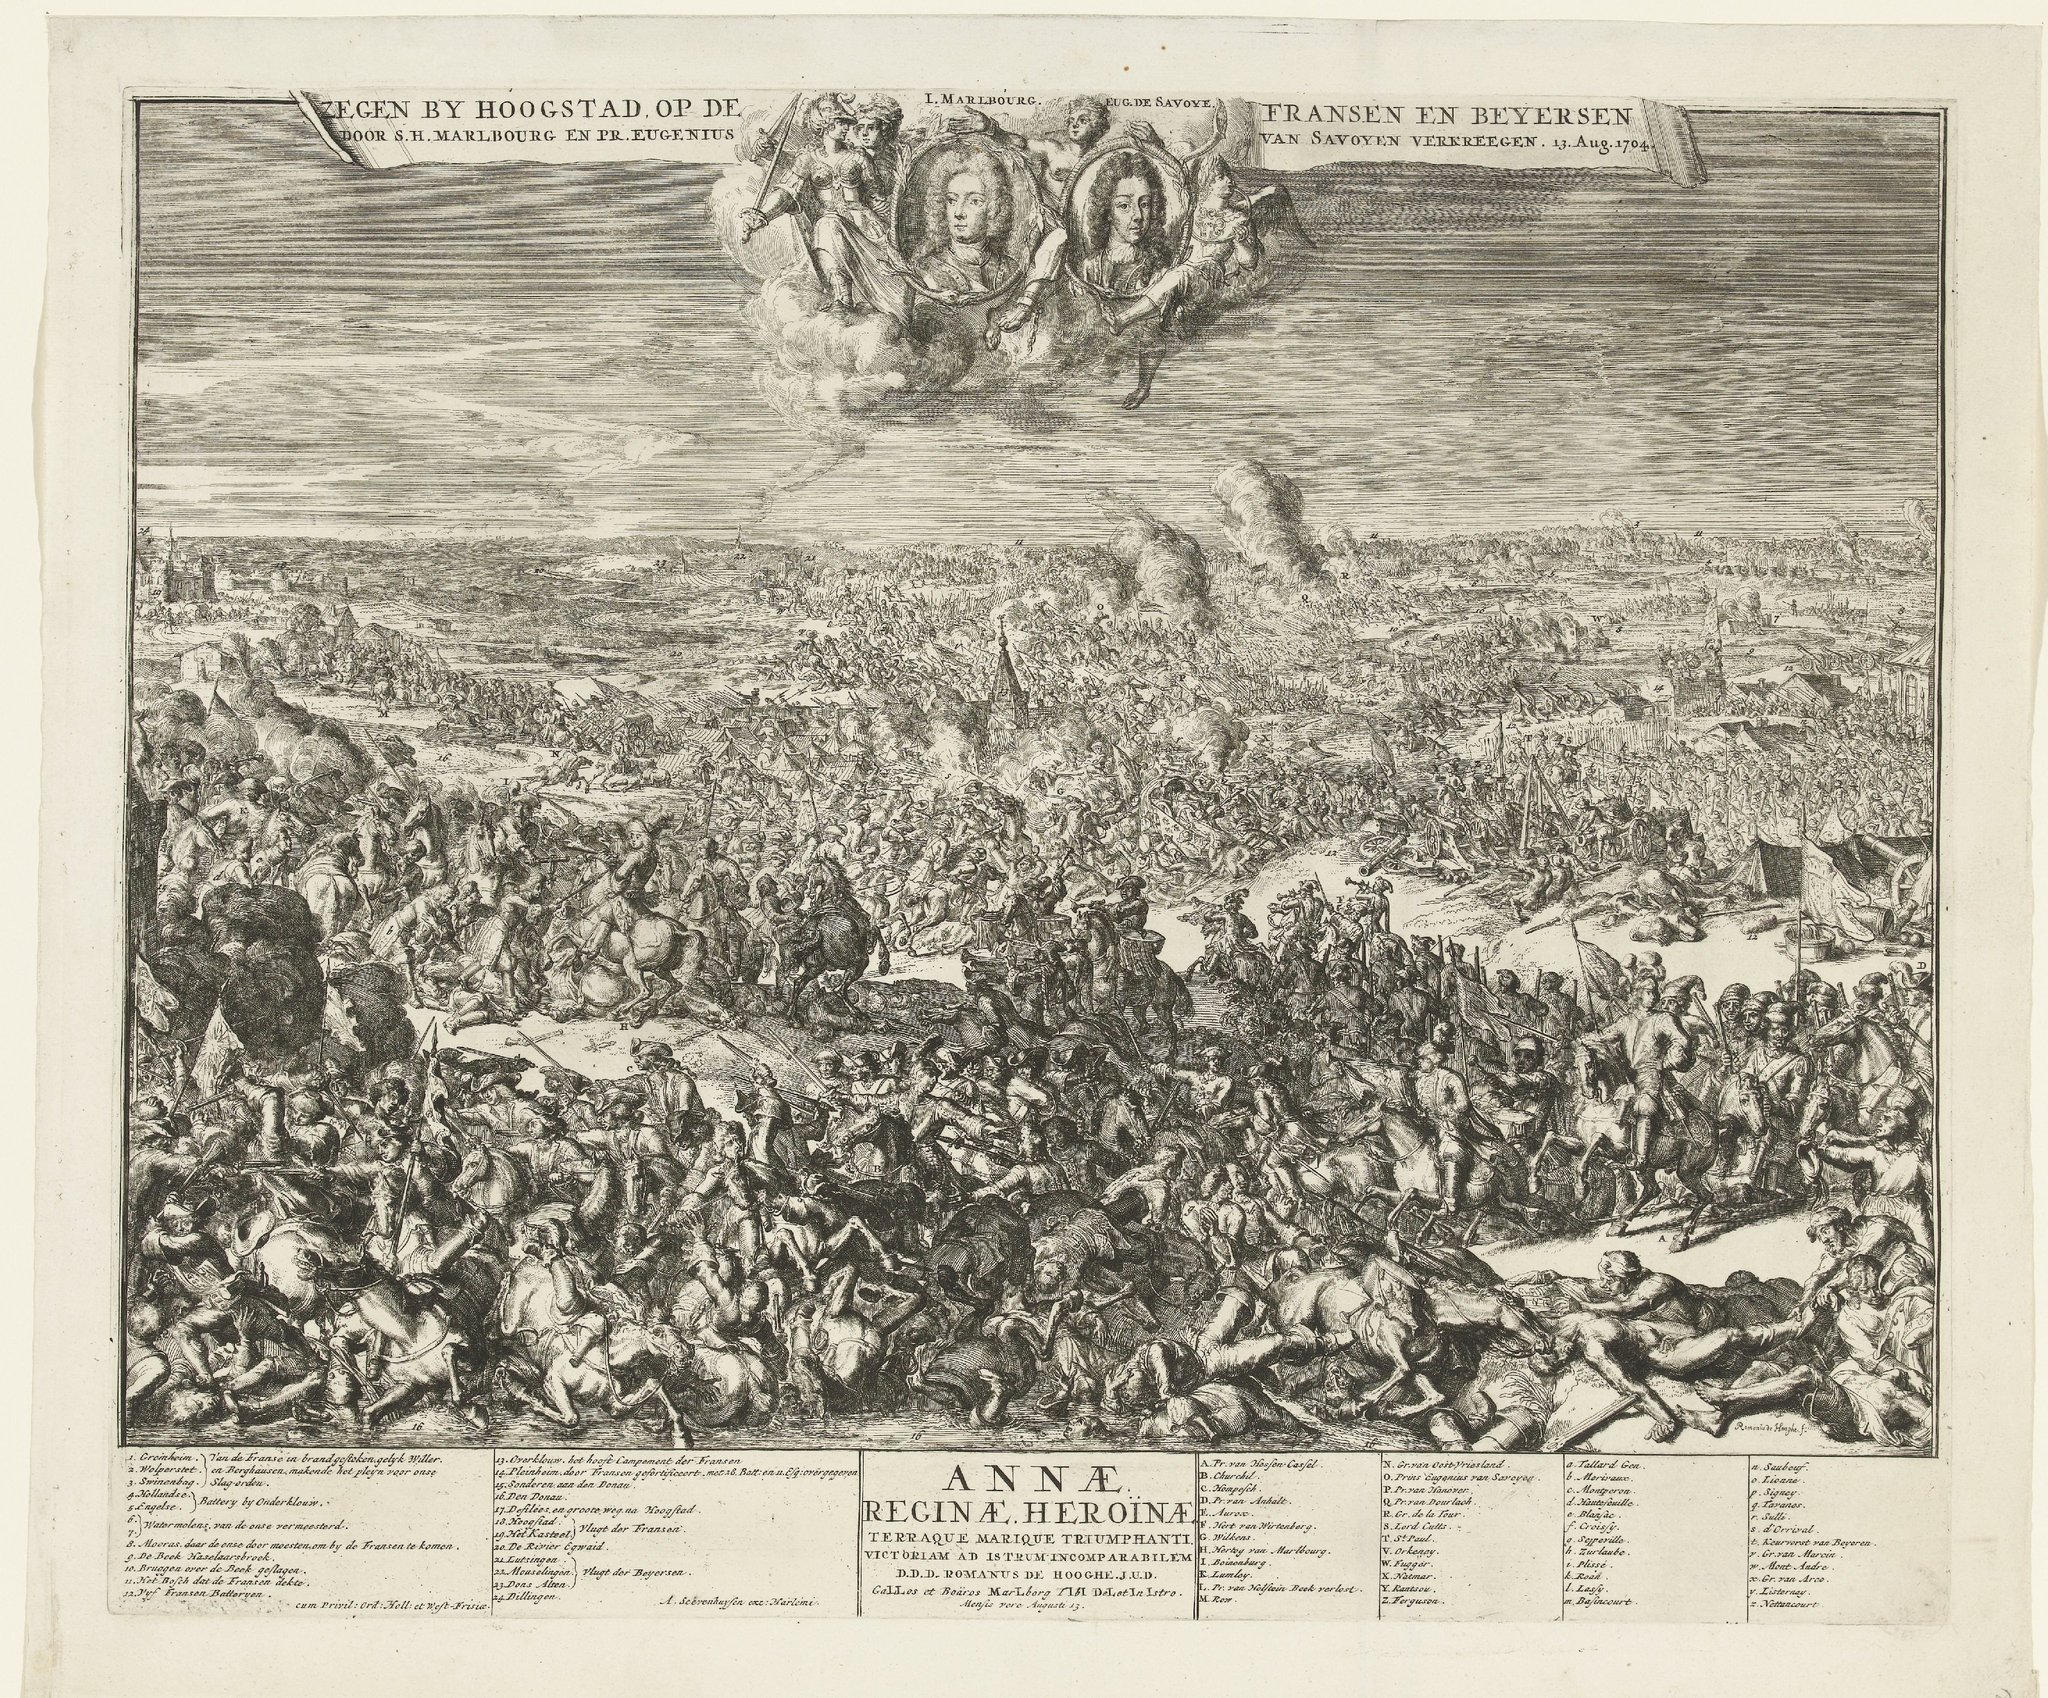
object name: print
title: Zegen by Hoogstad op de Fransen en Beyersen Door S.H. Marbourg en Pr. Eugenius van Savoyen verkreegen. 13. Aug. 1704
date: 1704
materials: paper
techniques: etching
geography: haarlem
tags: paris, vienna, eugenius van savoye, john churchill (1e hertog van marlborough), battle, fighting in general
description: Slag bij Höchstädt, bij Blenheim, in Beieren op 13 augustus 1704. Overwinning van de geallieerde troepen onder de hertog van Marlborough en de prins van Savoye, wier portretten bovenaan de voorstelling staan, op de Franse en Beierse troepen. In het onderschrift de legenda's 1-24 en A-z.